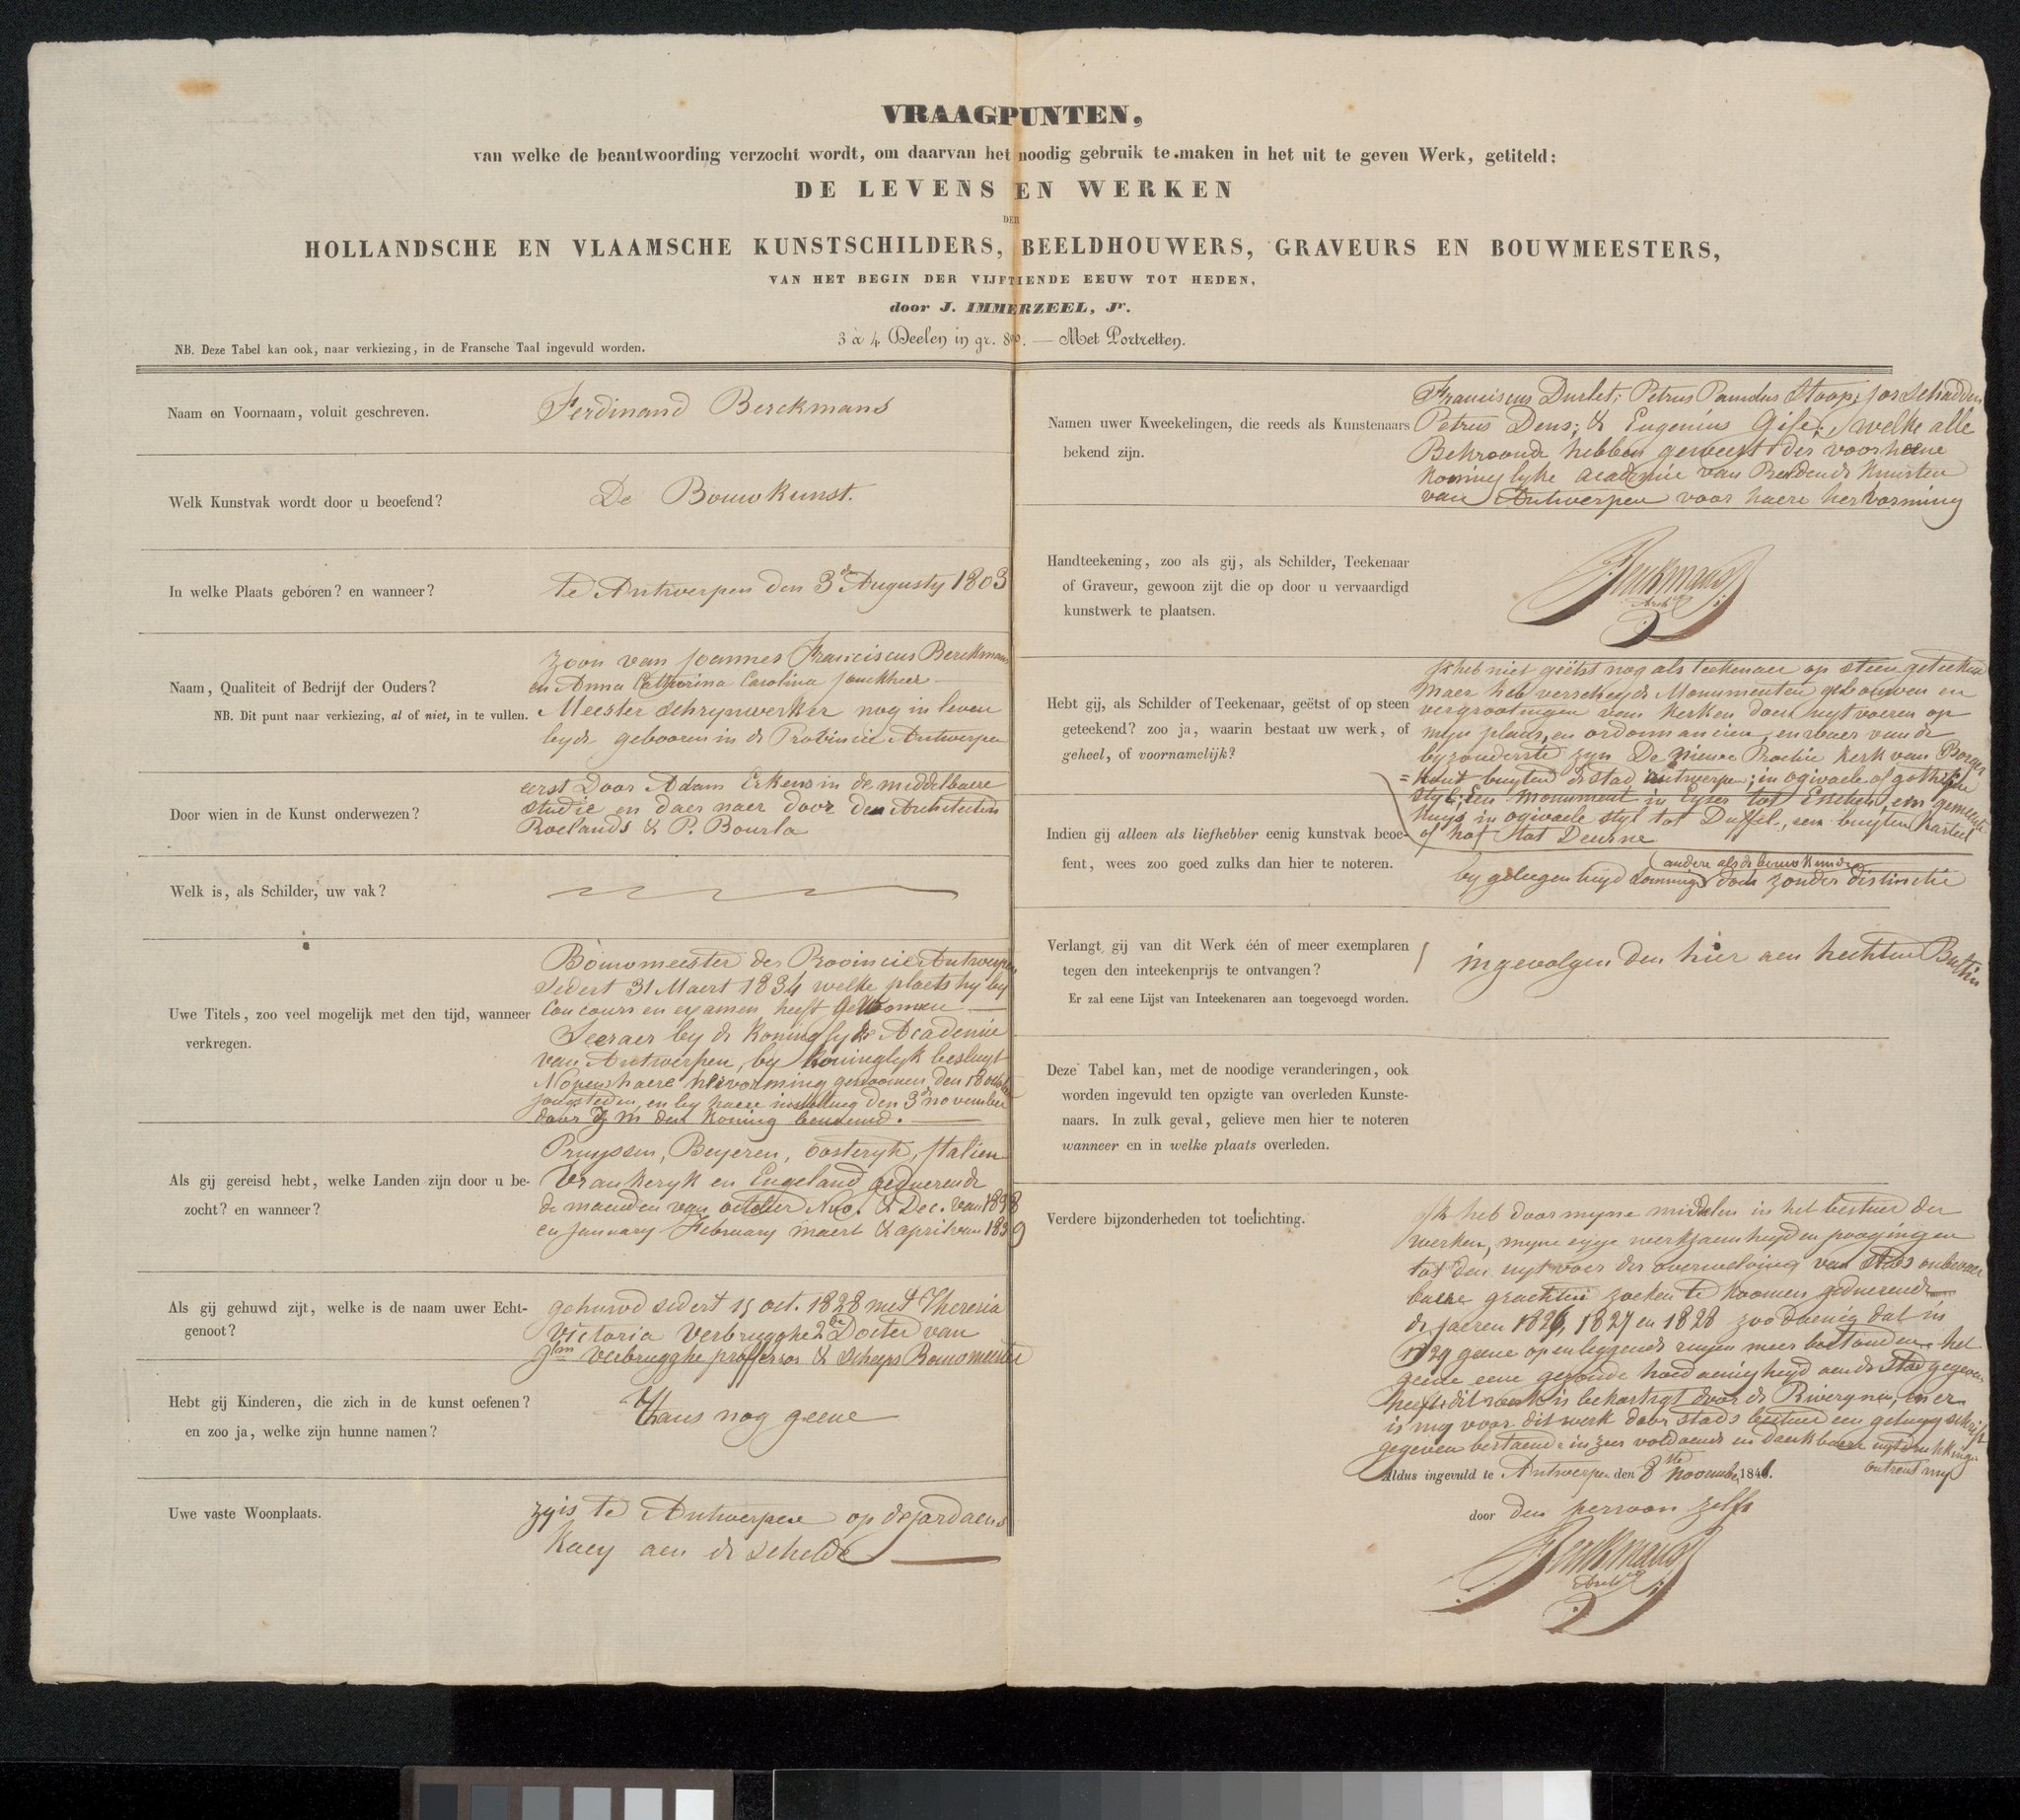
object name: questionnaire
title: Enquêteformulier ingevuld door Ferdinand Berckmans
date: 1841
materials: ink, paper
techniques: pen, printing, writing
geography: antwerp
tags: ferdinand berckmans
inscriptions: inscription: ‘Vraagpunten,/ van welke de beantwoording verzocht wordt, om daarvan het noodig gebruik te maken in het uit te geven Werk, getiteld: De levens en werken/ der Hollandsche en Vlaamsche kunstschilders, beeldhouwers,/ graveurs en bouwmeesters, van het begin der vijftiende eeuw tot heden/ door J. Immerzeel, Jr.’, watermark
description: Opgenomen in: Immerzeel, J. Jr., De levens en werken der Hollandsche en Vlaamsche kunstschilders, beeldhouwers, graveurs en bouwmeesters, van het begin der vijftiende eeuw tot heden, Amsterdam: J.C. van Kesteren, 1842-1843.